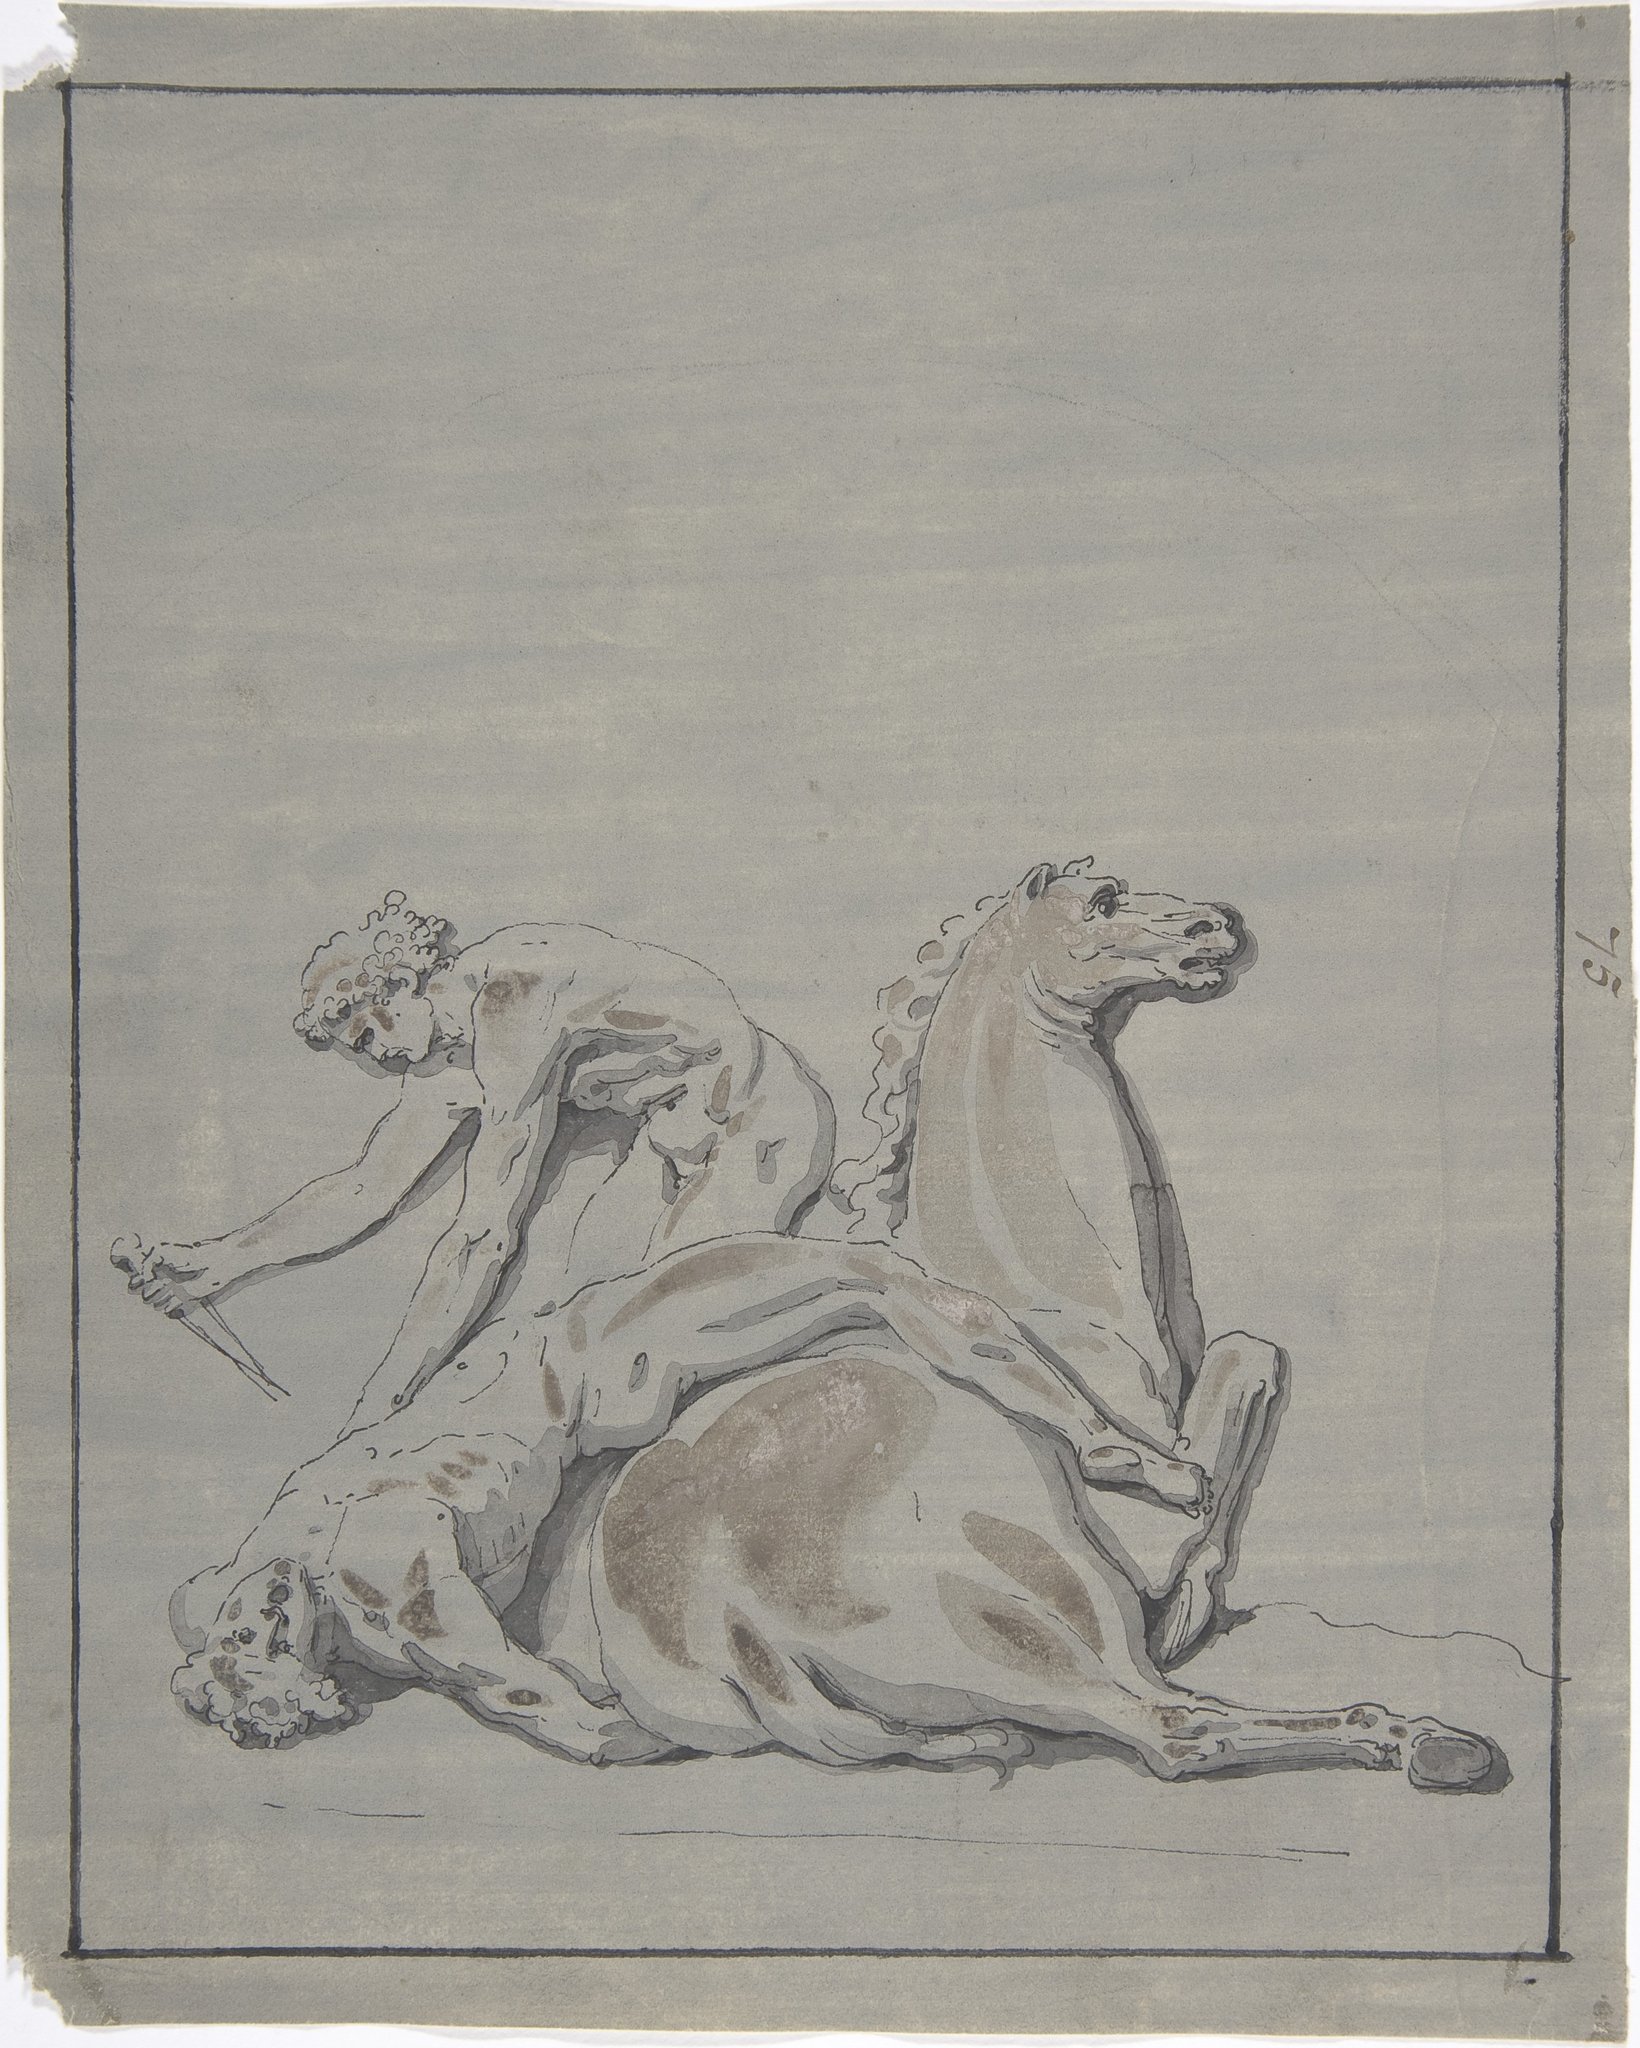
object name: drawing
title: Battle Scene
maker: anonymous, french, 18th century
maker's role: artist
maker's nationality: french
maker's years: 1700-1800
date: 1701-1800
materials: ink, paper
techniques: brush, pen, wash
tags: battles,suffering,men,horses